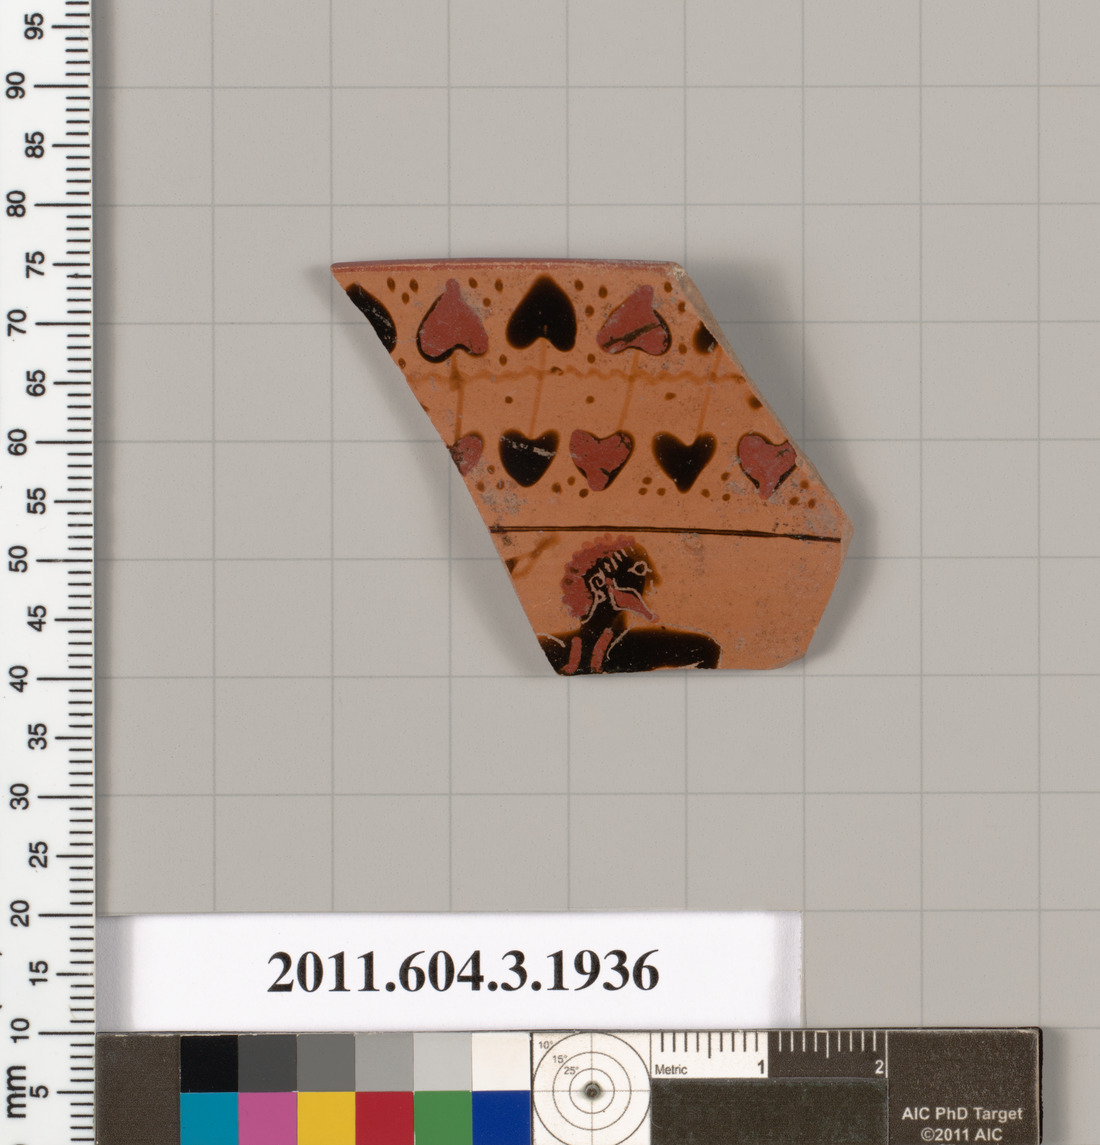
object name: kylix fragment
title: Terracotta fragment of a kylix: Siana cup (drinking cup)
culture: greek, attic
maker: heidelberg painter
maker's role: artist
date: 560-550 BCE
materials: terracotta